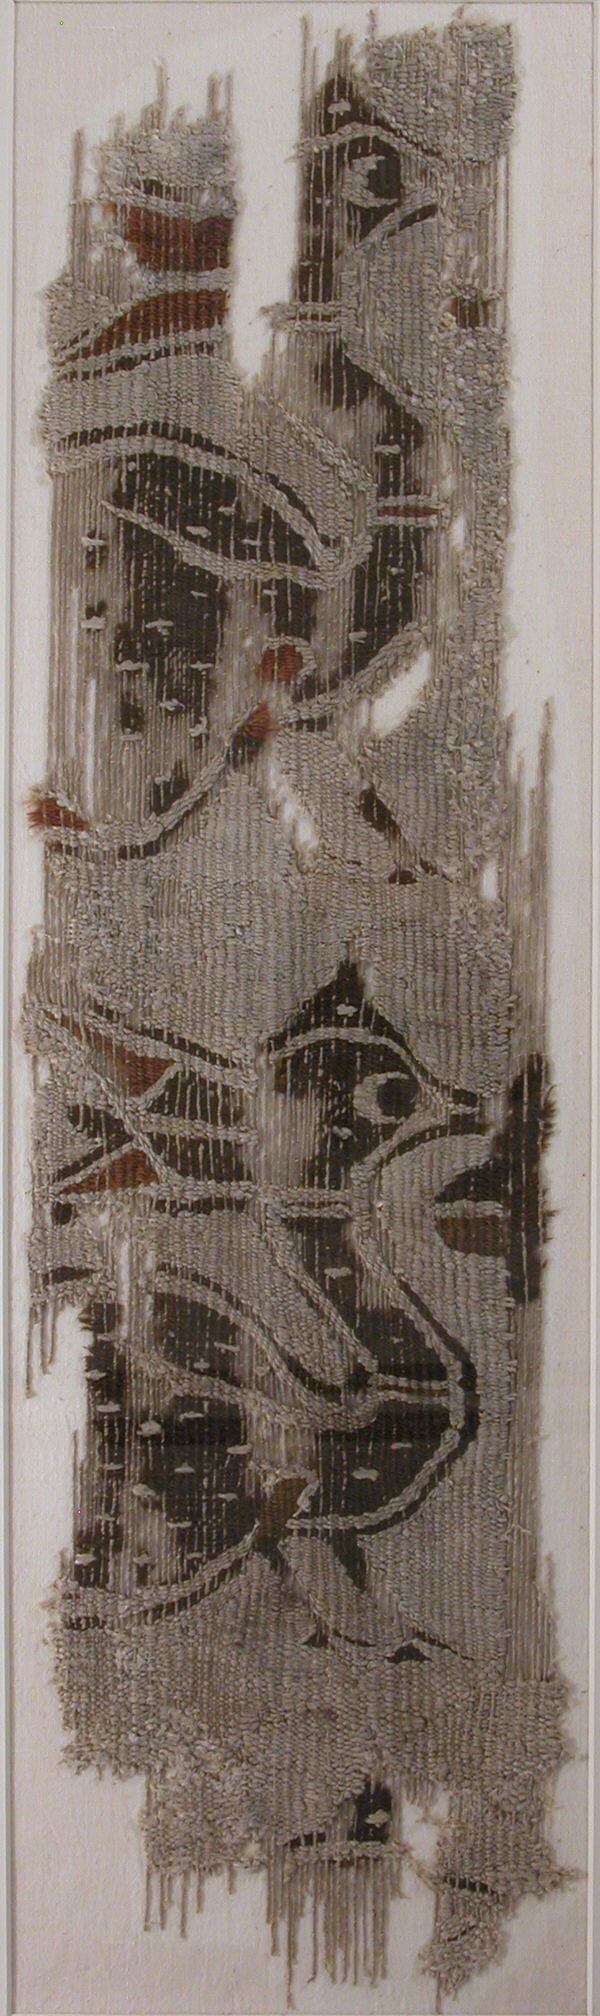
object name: textile fragment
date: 801-1000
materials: linen, wool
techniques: weave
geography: egypt